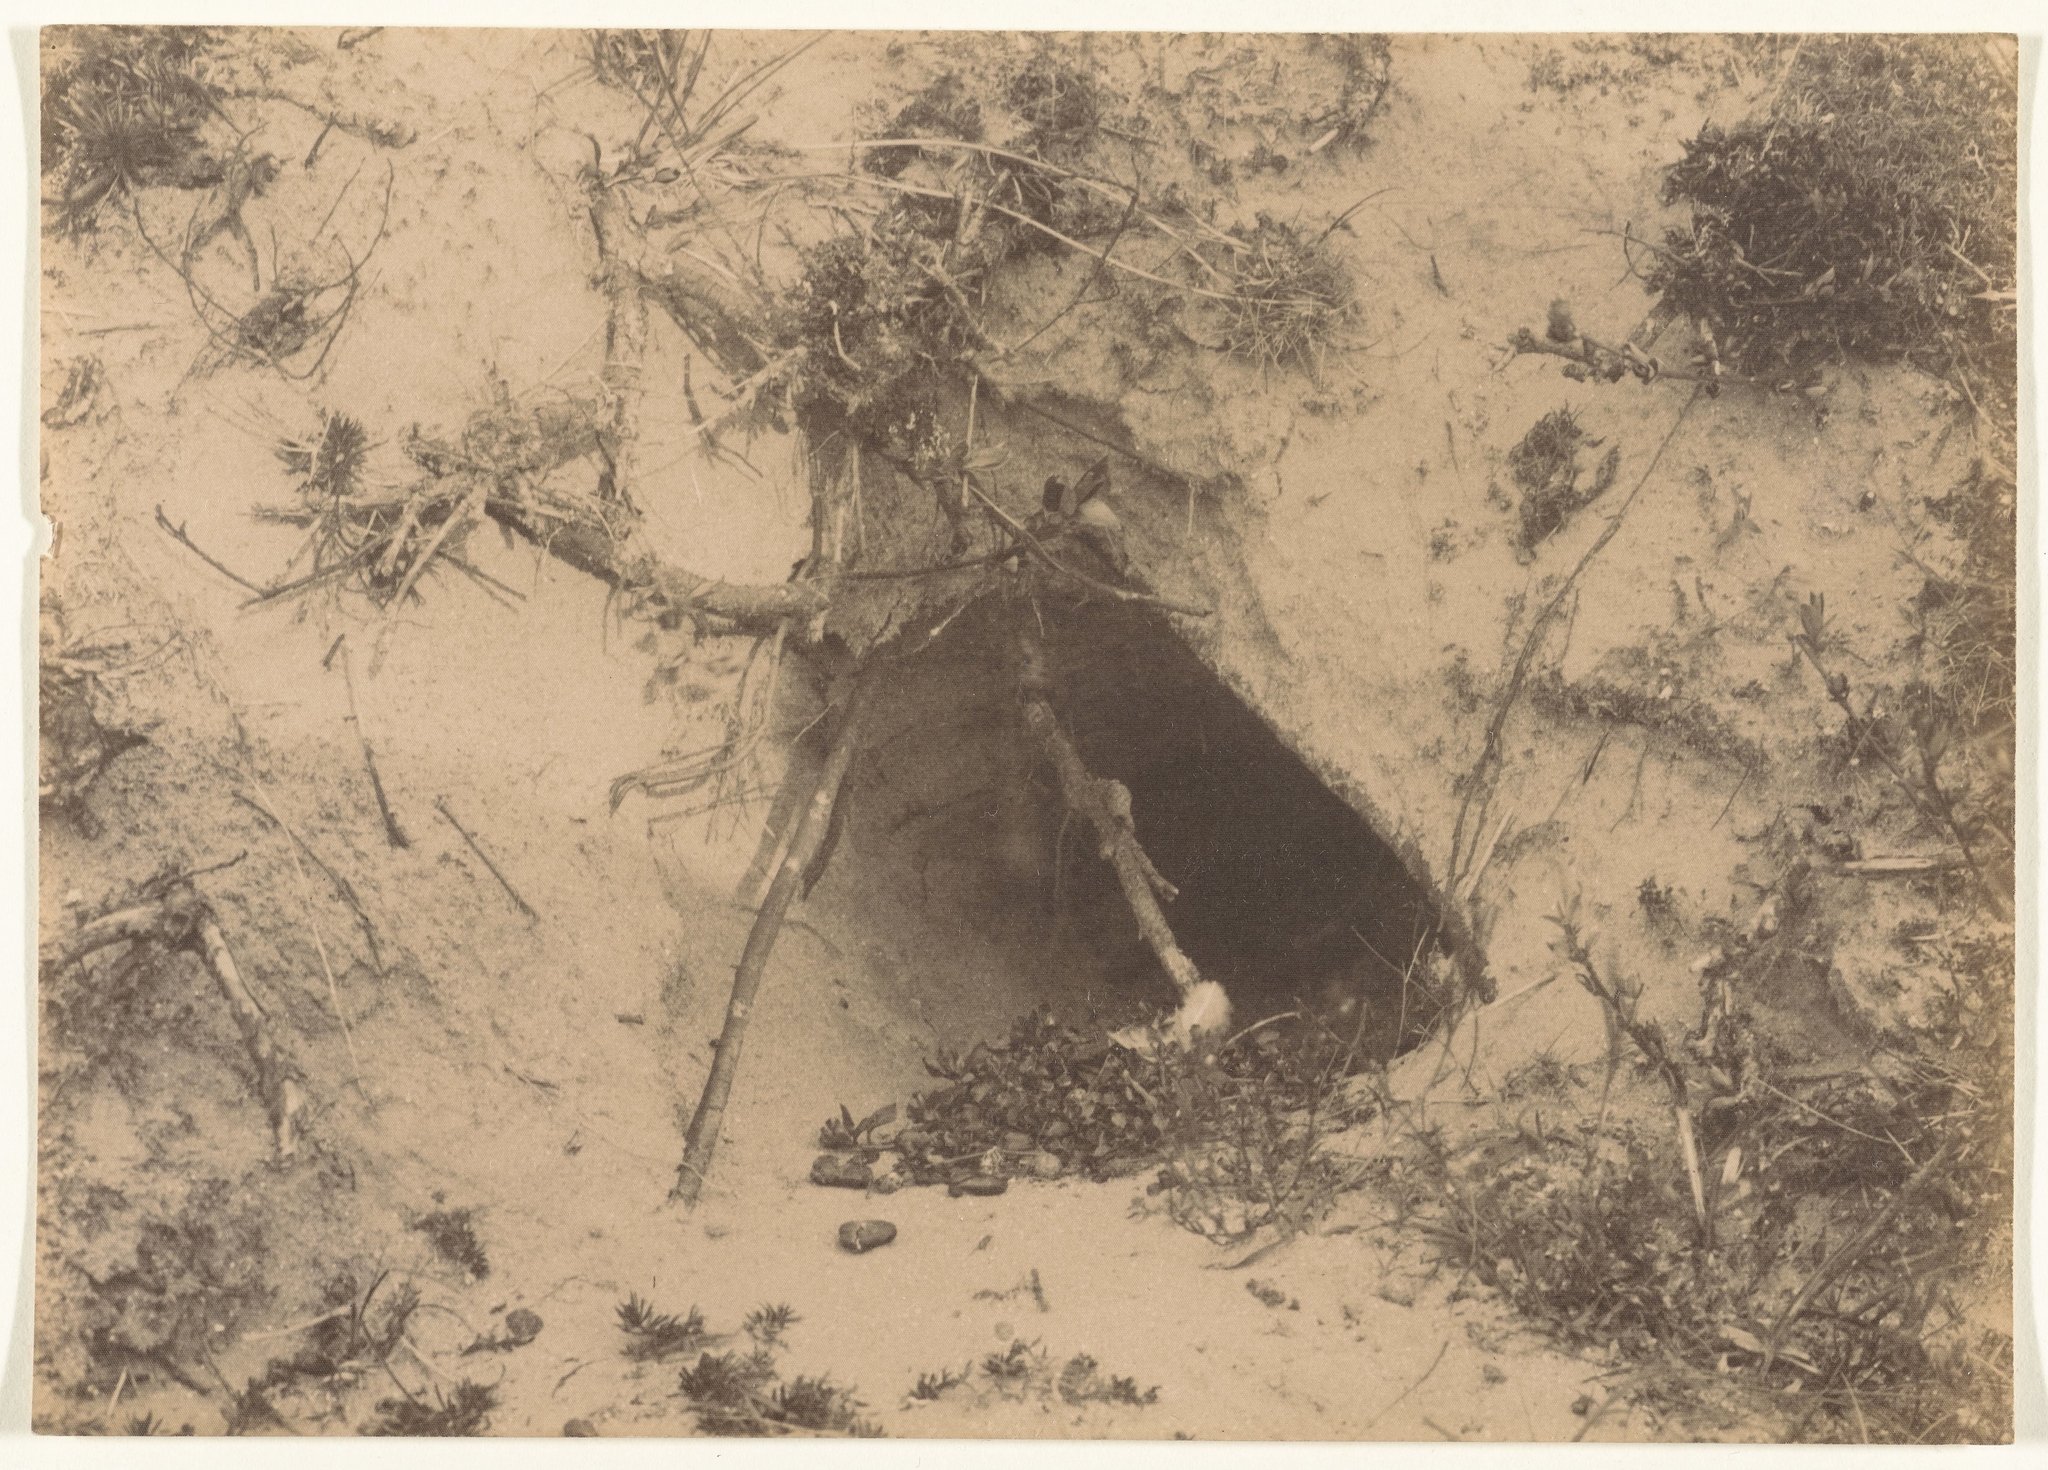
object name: photograph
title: Ingang van een vossenhol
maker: richard tepe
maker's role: fotograaf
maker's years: 1864-1952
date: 1900-1930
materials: paper, photographic support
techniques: gelatin silver print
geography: netherlands